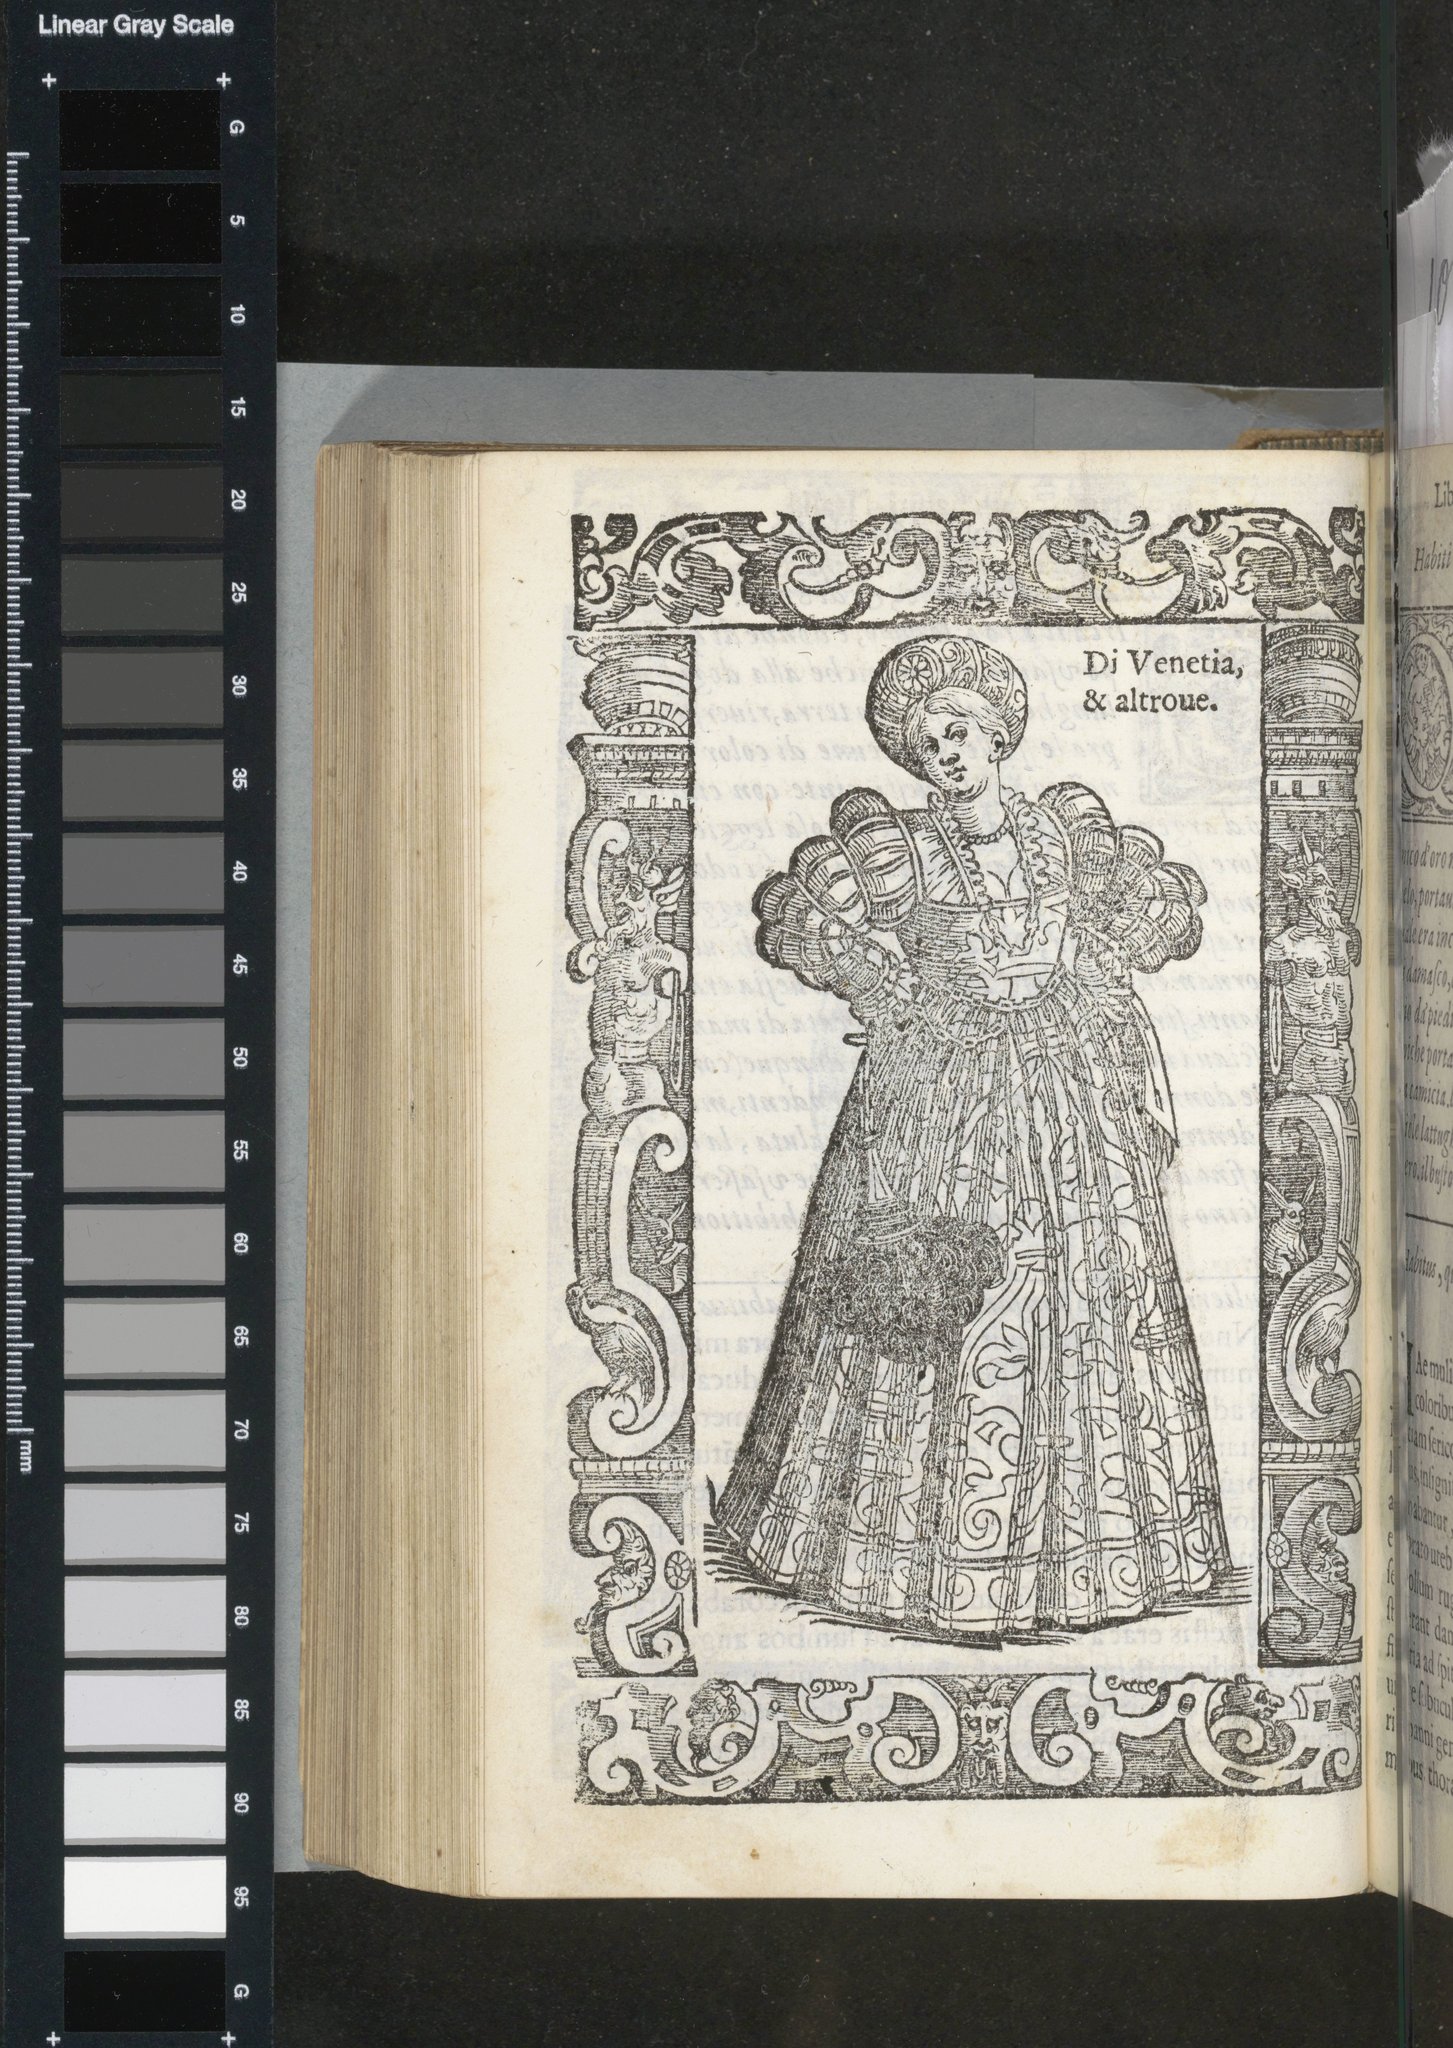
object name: costume print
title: Di venetia & altrove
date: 1598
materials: paper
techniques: woodcut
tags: fashion plates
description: Venetiaanse vrouw met tulband op het hoofd. Een grote veren stokwaaier hangt aan de ceintuur van haar gewaad.